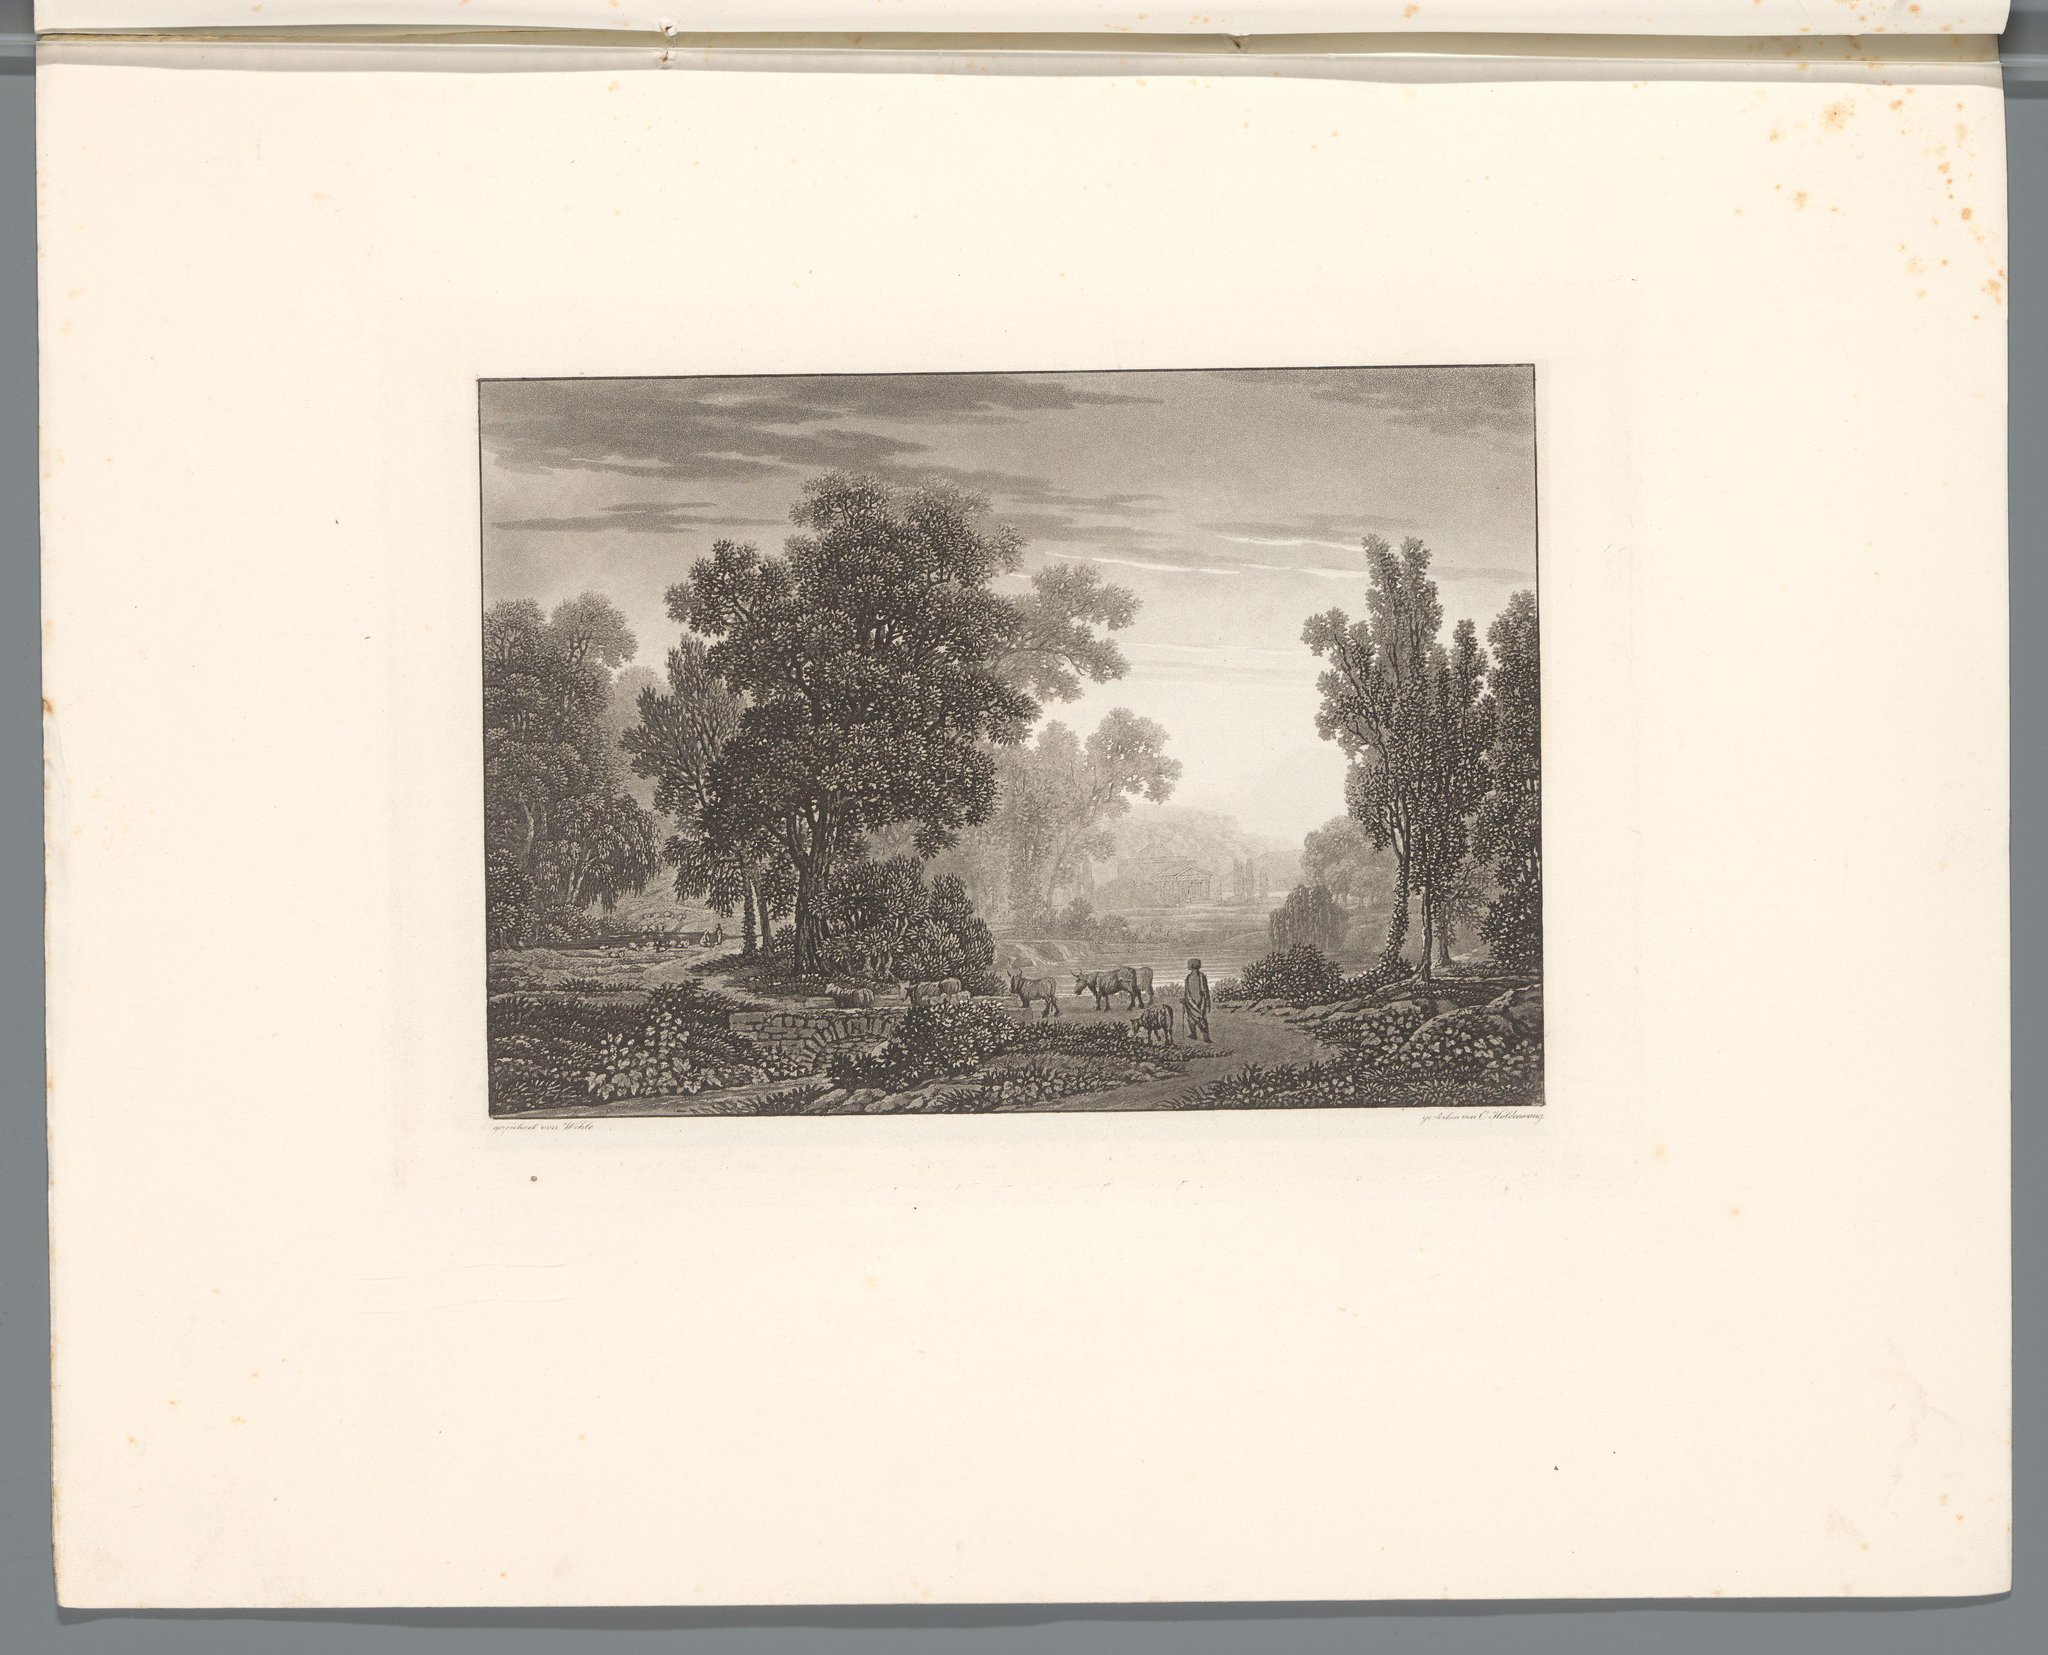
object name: print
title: Landschap met herders en in de verte een tempel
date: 1804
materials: paper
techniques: aquatint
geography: karlsruhe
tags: landscapes in the temperate zone - hh - ideal landscapes, herding, herdsman, herdswoman, shepherd, shepherdess, cowherd, etc.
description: Prent uit: Haldenwang, Christian. 6 Landschaftliche Entwürfe nach Wehle in Aqua tinta geätzt vom C. Haldenwang. Karlsruhe: Franz Nöldeke, [1804].